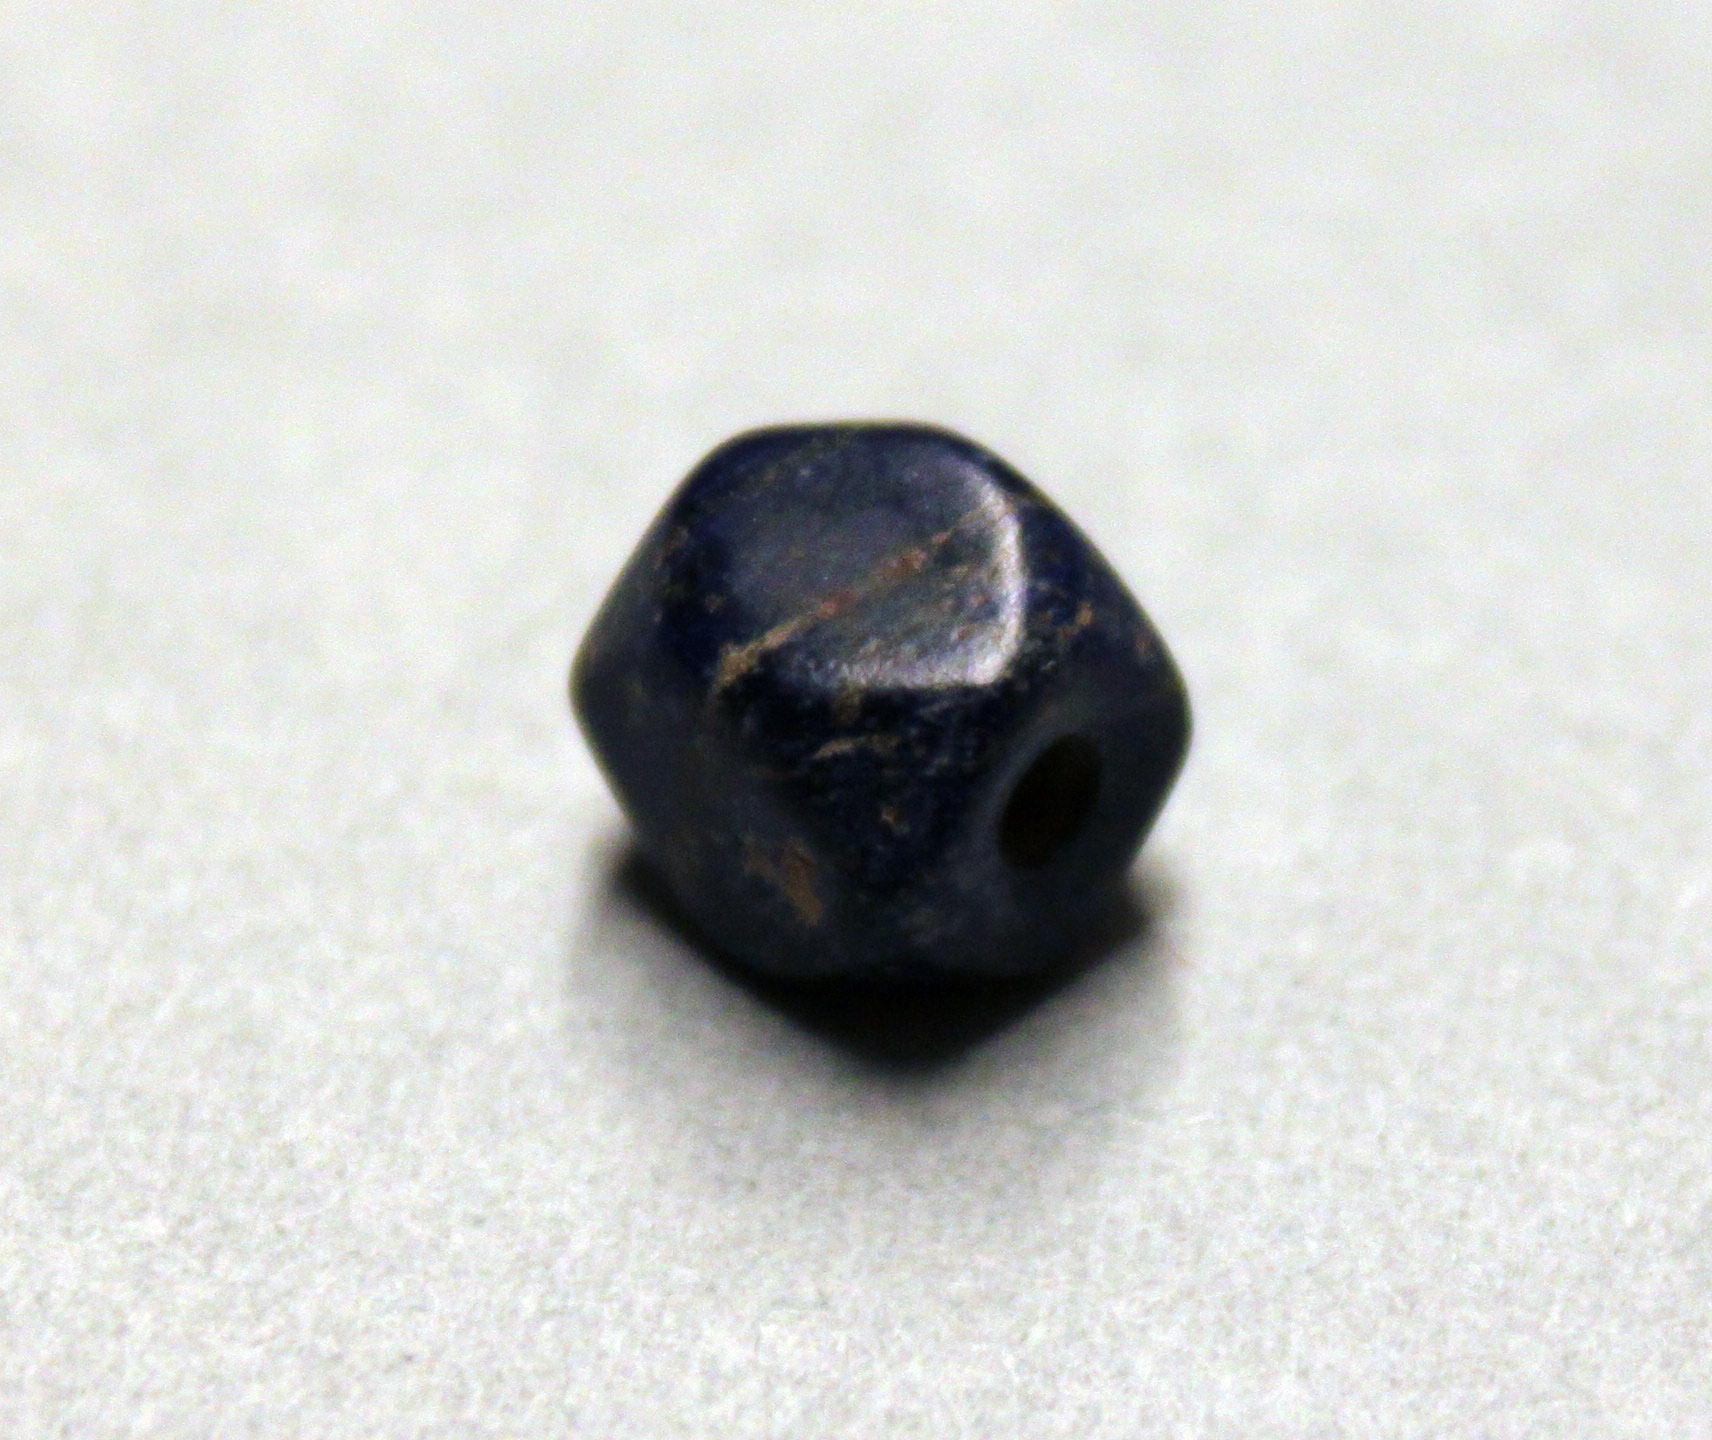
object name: bead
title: Beads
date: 801-1200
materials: lapis lazuli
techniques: cutting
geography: iran